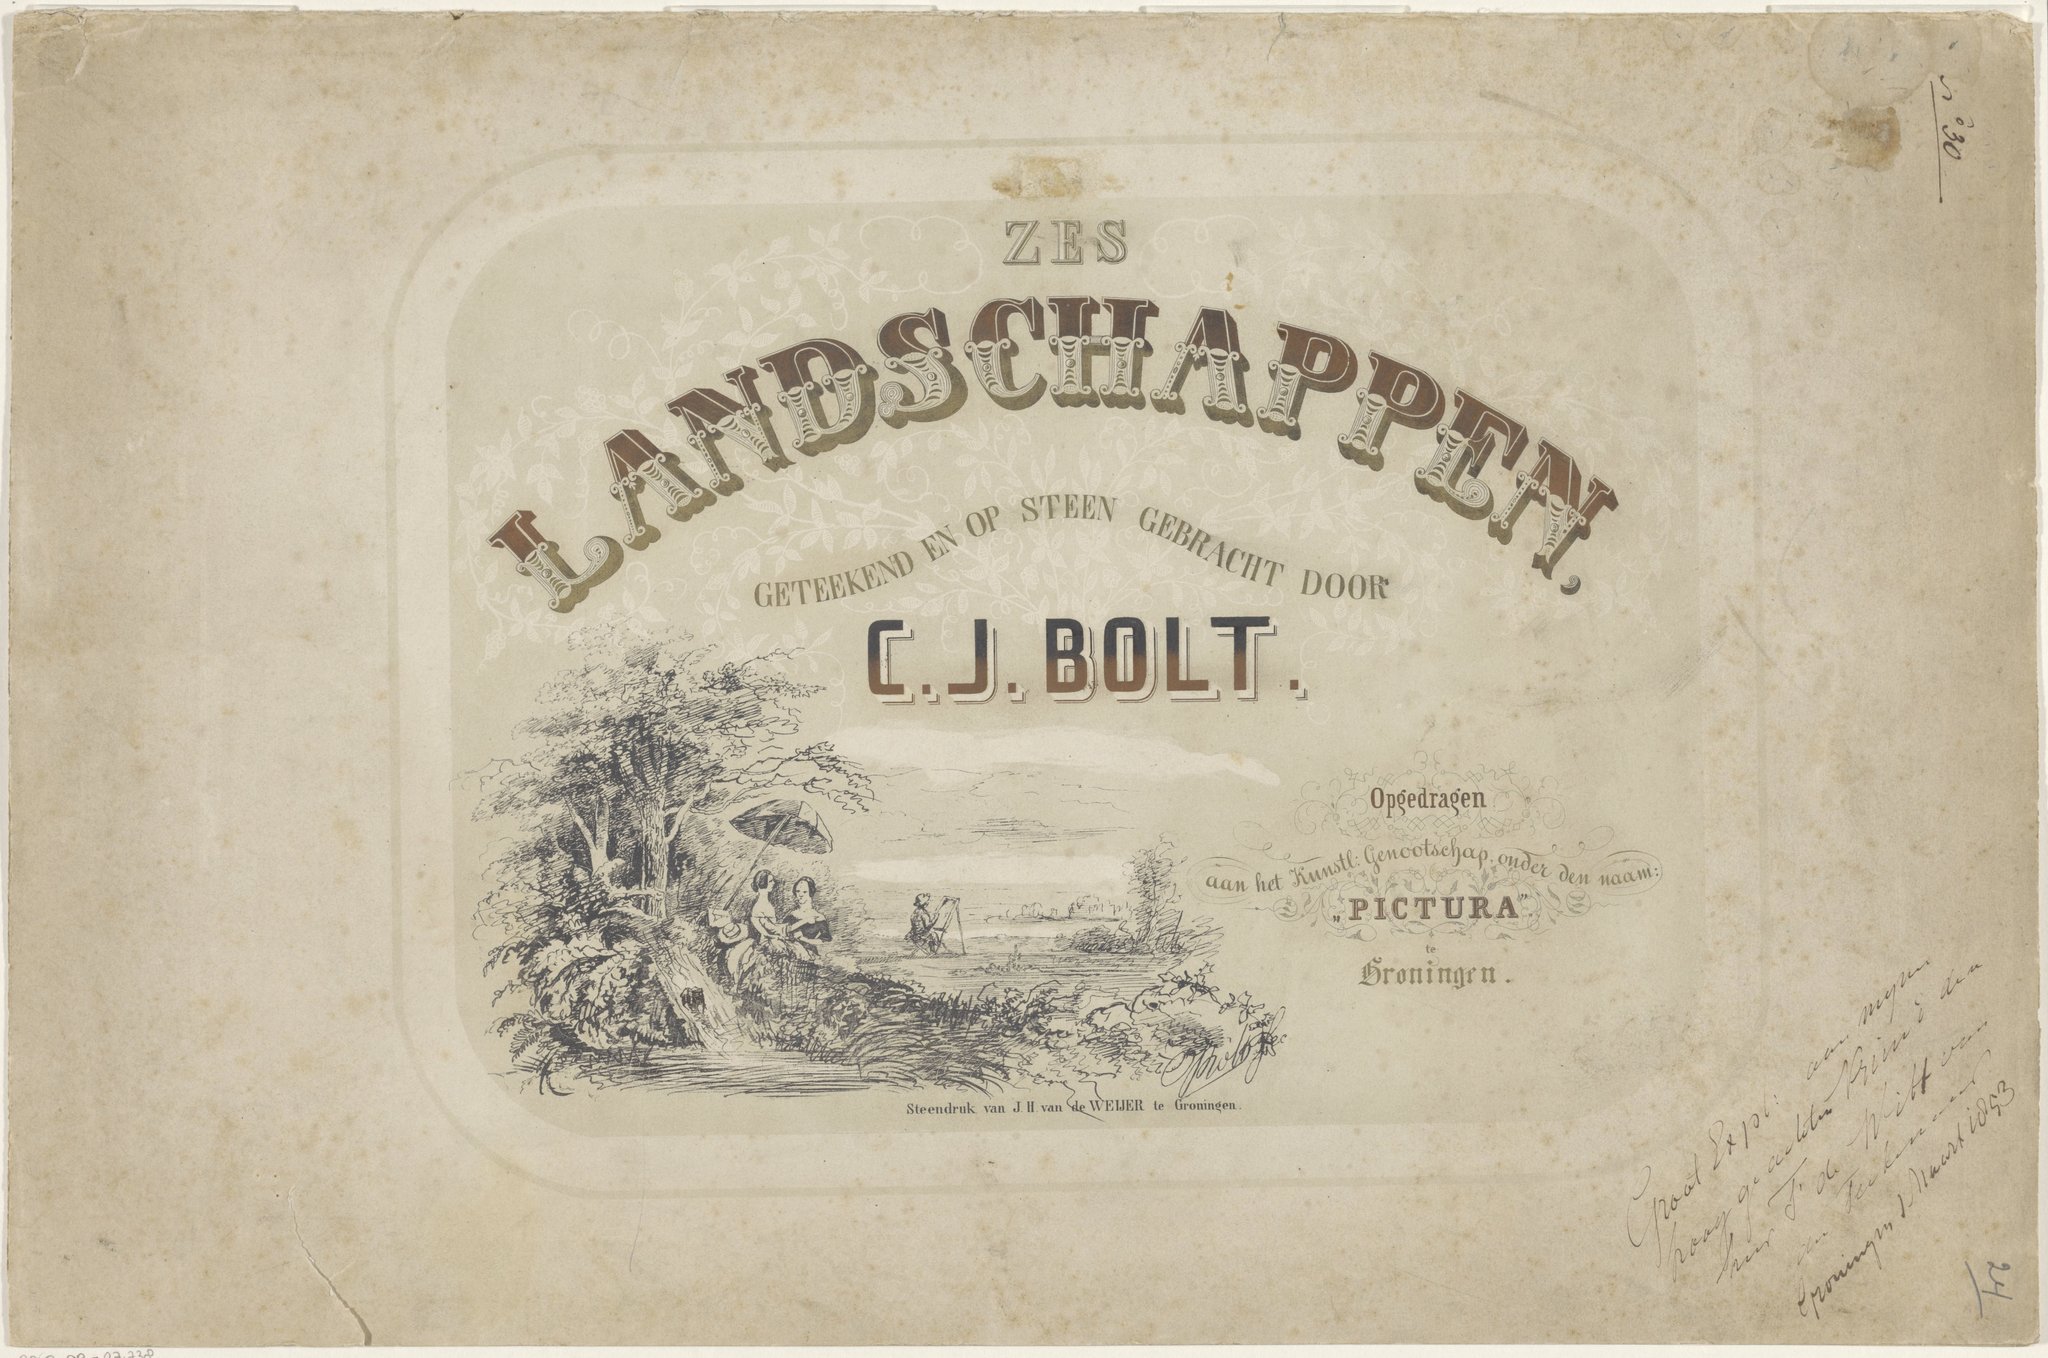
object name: titelprent, frontispice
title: Zes landschappen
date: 1833-1879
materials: paper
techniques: lithograph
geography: groningen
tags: sitting figure - aa - female human figure, title-page, artist (in general) making preliminary designs, sketching - bb - out of doors, parasol, sunshade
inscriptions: inscription: ‘Groot Expl: aan mijnen / hooggeachten (...) den / heer T. de Witt van / den Teekenaar / Groningen 1 maart 1893’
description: Bij enkele bomen zitten twee vrouwen onder een parasol. Vederop zit een kunstenaar achter zijn ezel het landschap te tekenen.